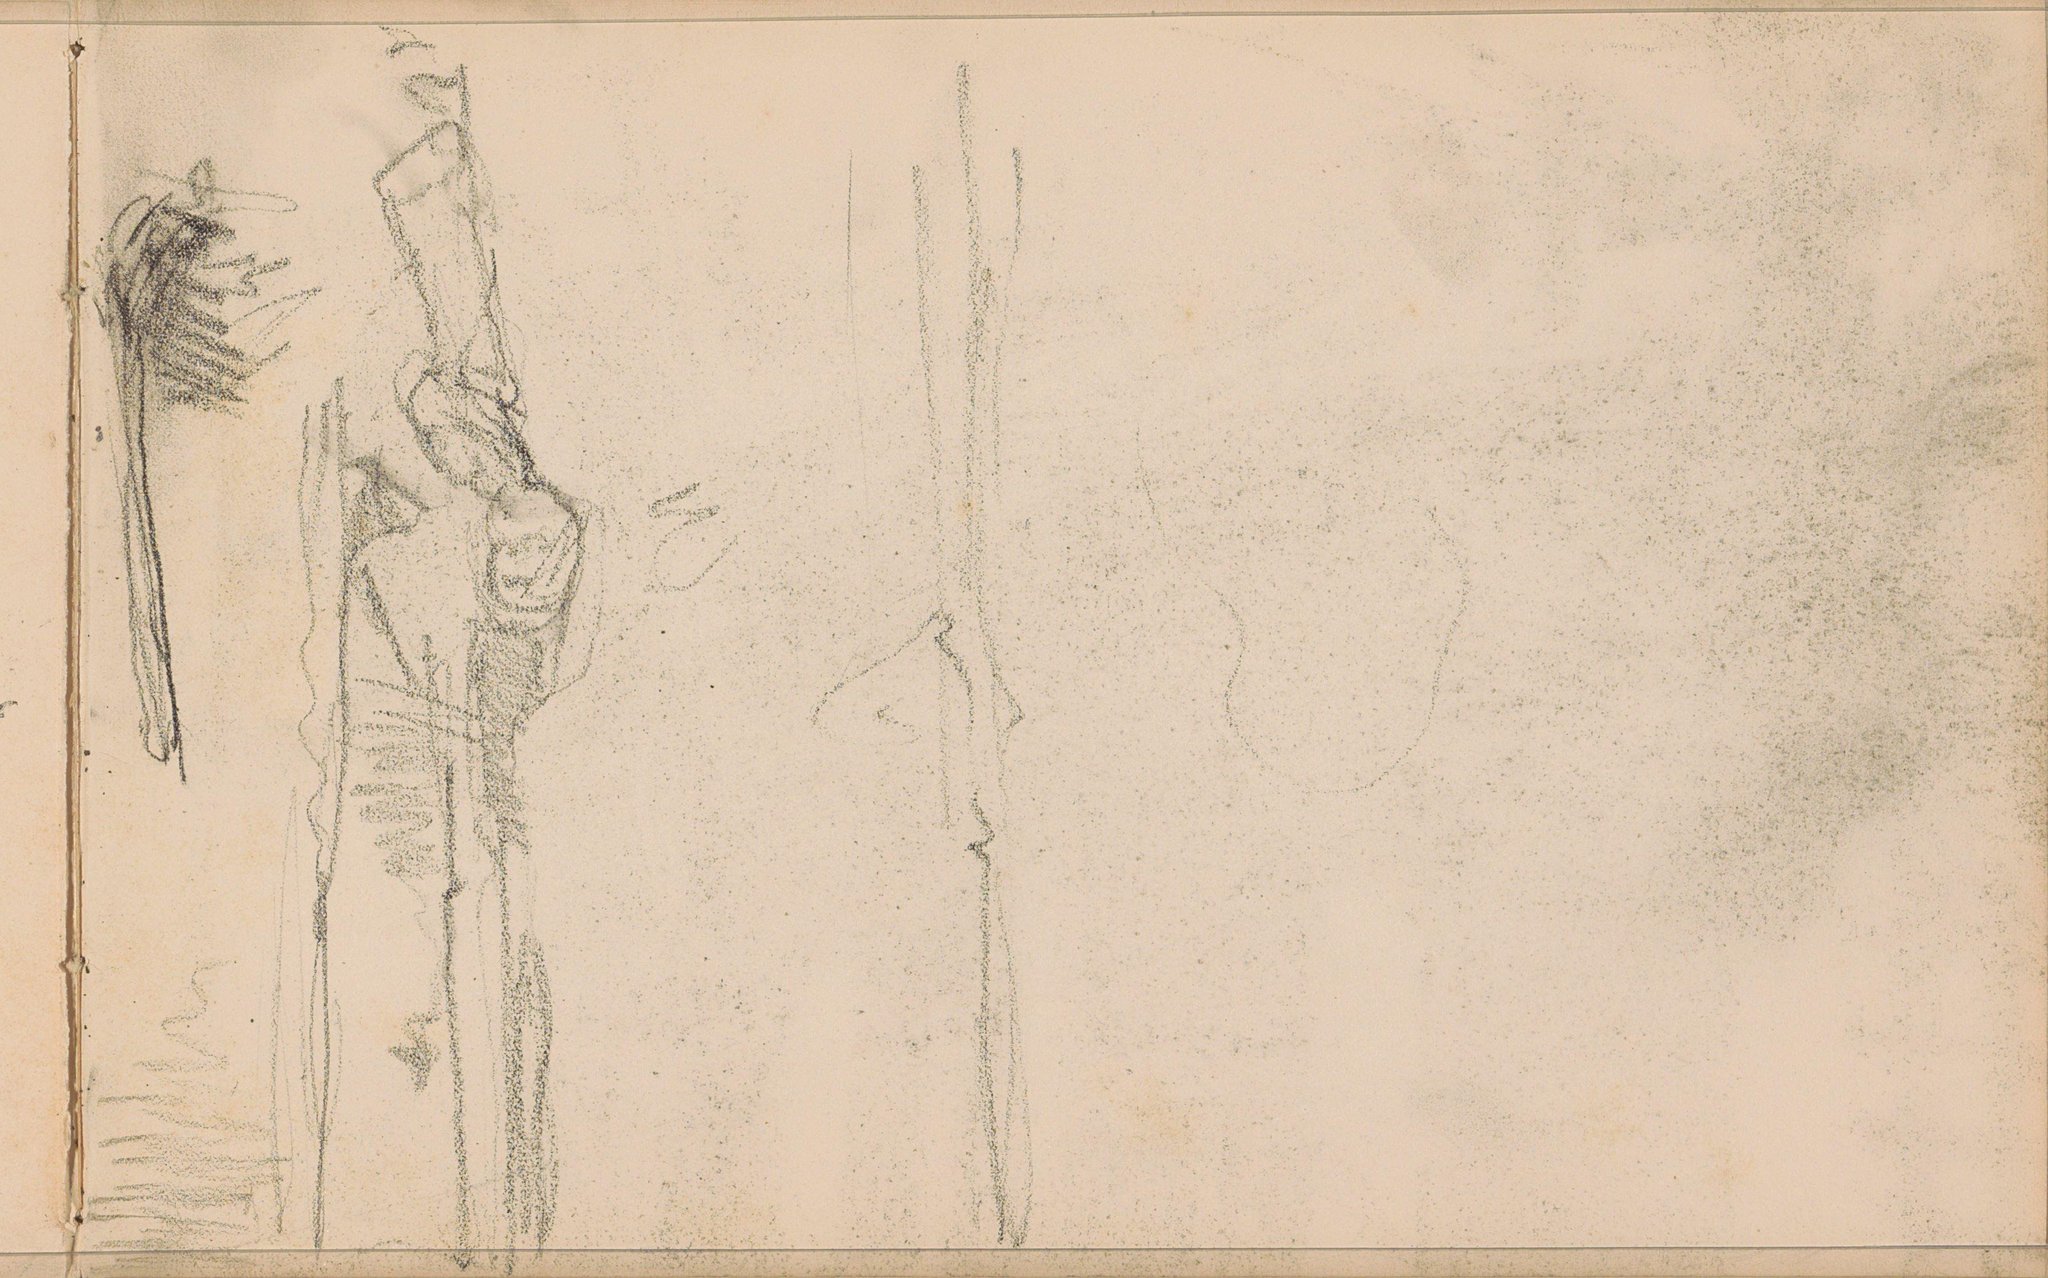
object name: sketchbook leaf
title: Studie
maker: a.a.l. de grammont-hubrecht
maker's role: draughtsman, painter, print maker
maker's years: 1855-1913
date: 1865-1913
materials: chalk, paper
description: Blad 54 recto uit een schetsboek met 65 bladen.